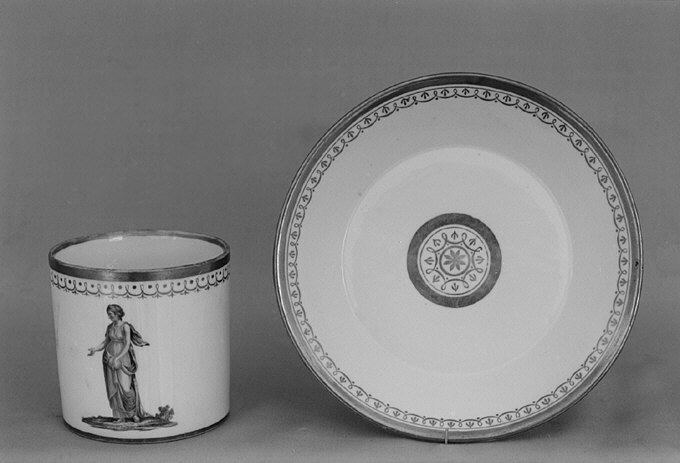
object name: saucer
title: Saucer (part of a coffee service)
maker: nymphenburg porcelain manufactory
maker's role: manufactory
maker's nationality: german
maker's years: 1747-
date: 1801-1833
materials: hard paste porcelain